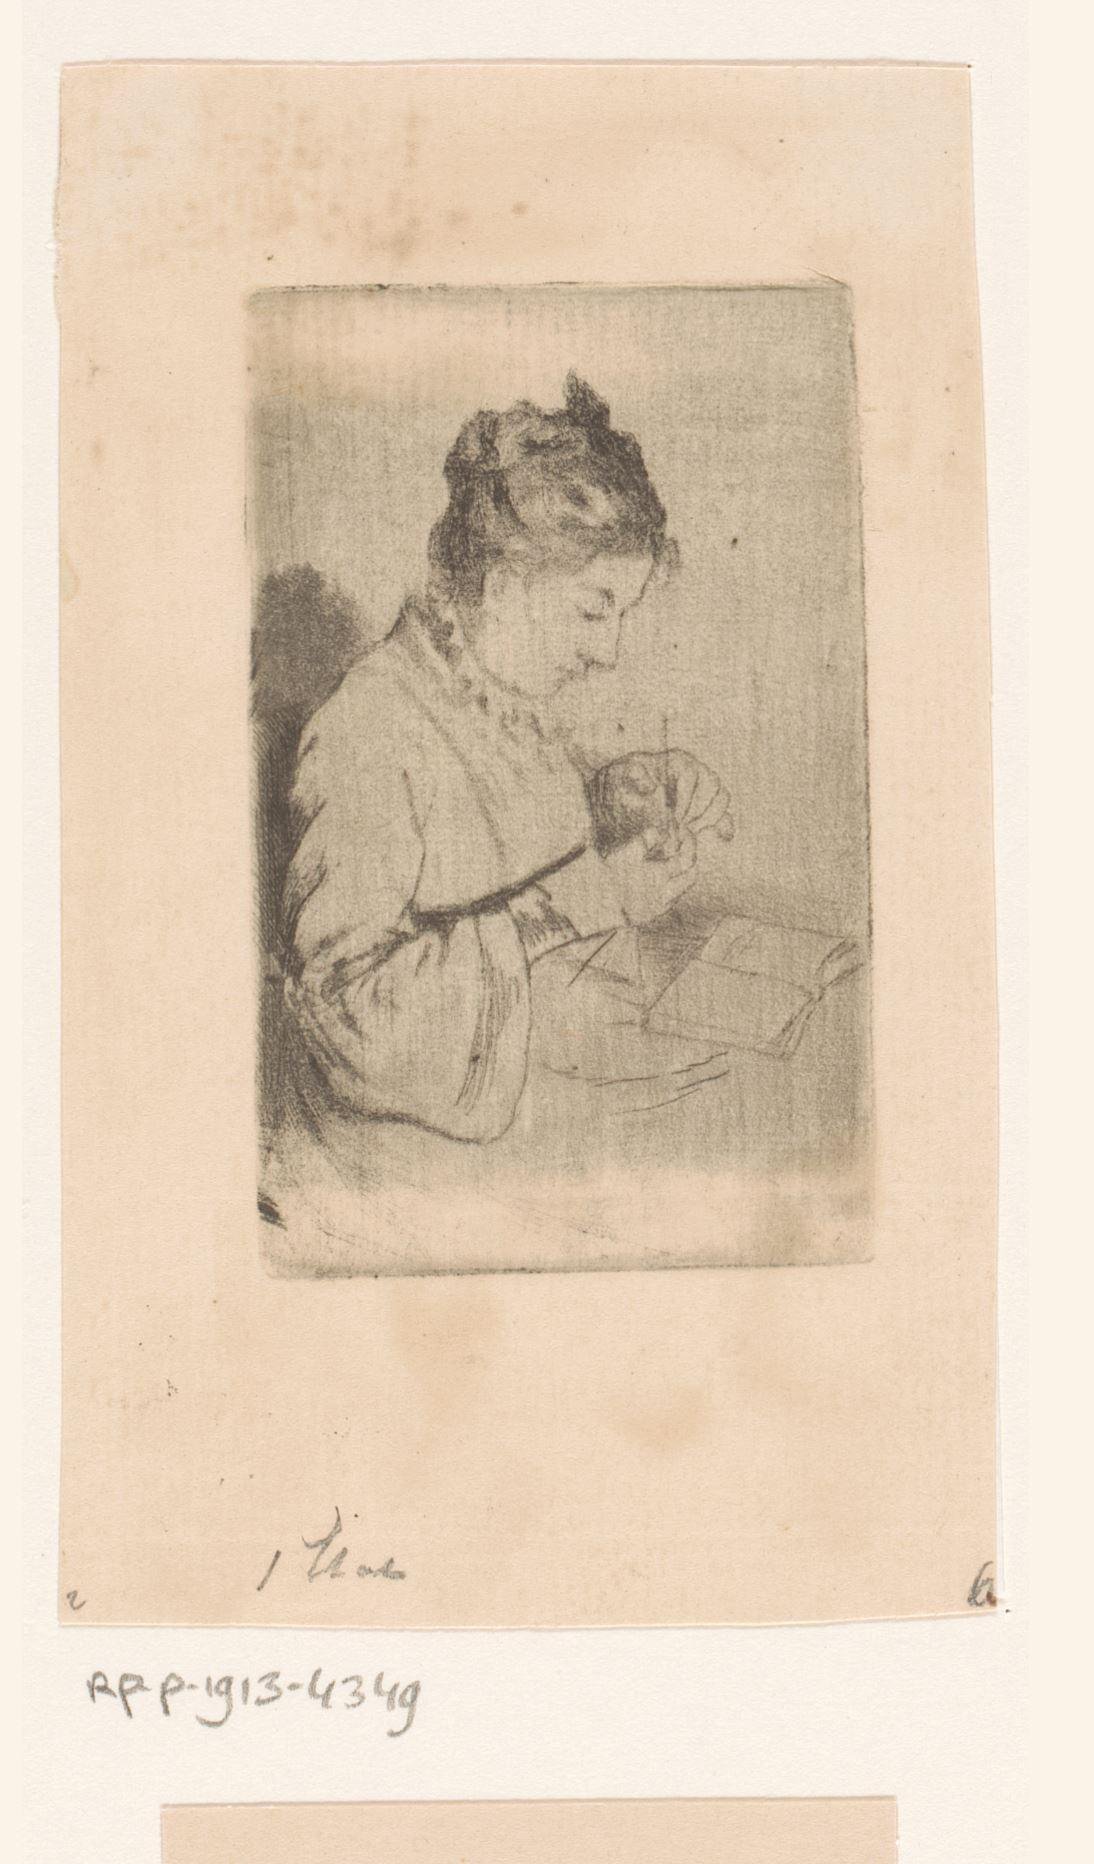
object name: print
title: Vrouw met boek op schoot en naald in haar handen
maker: adrien de witte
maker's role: print maker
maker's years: 1850-1935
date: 1877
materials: paper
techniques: etching, intaglio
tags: adult woman, reading, book - mm - book open, needle ~ sewing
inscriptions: collector's mark: Lugt 2228